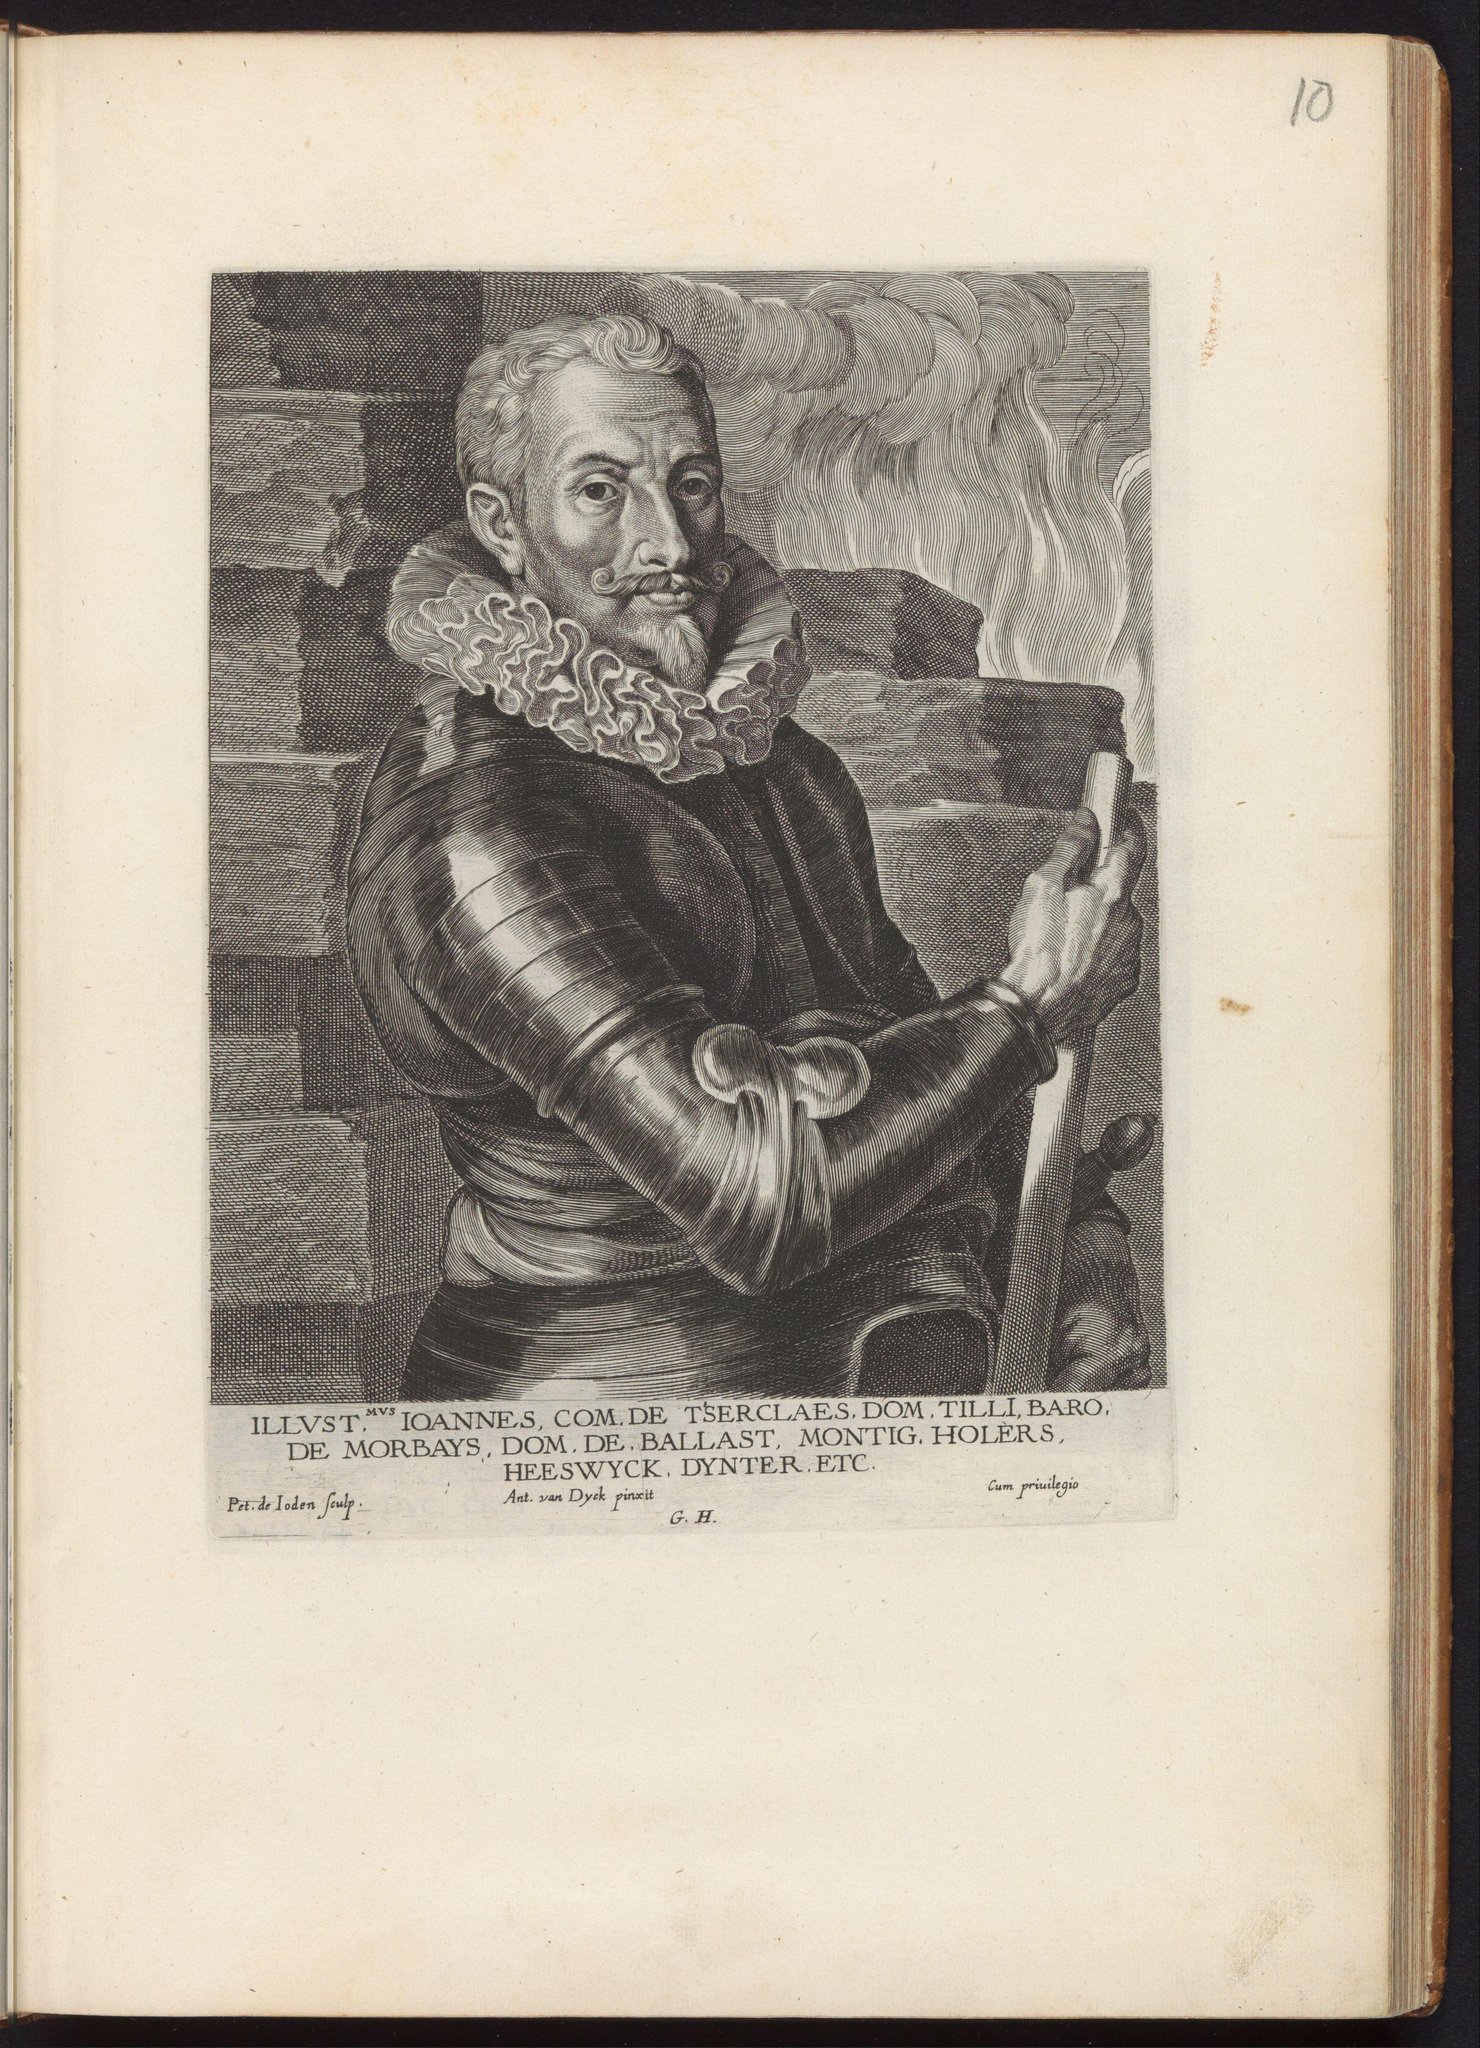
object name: print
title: Icones Principum Vivorum Doctorum Pictorum Chalcographorum Statuariorum nec non Amatorum Pictoriae Artis Numero Centum ab Antonio van Dyck Pictore ad Vivum Expressae Eiusq: Sumptibus aeri incisae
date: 1630-1641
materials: paper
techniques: engraving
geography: antwerp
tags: flame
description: Portret van Johannes 't Serclaes, graaf van Tilly. Hij draagt een harnas en staat voor een muur. Op de achtergrond woedt een brand. Deze prent maakt deel uit van een album.